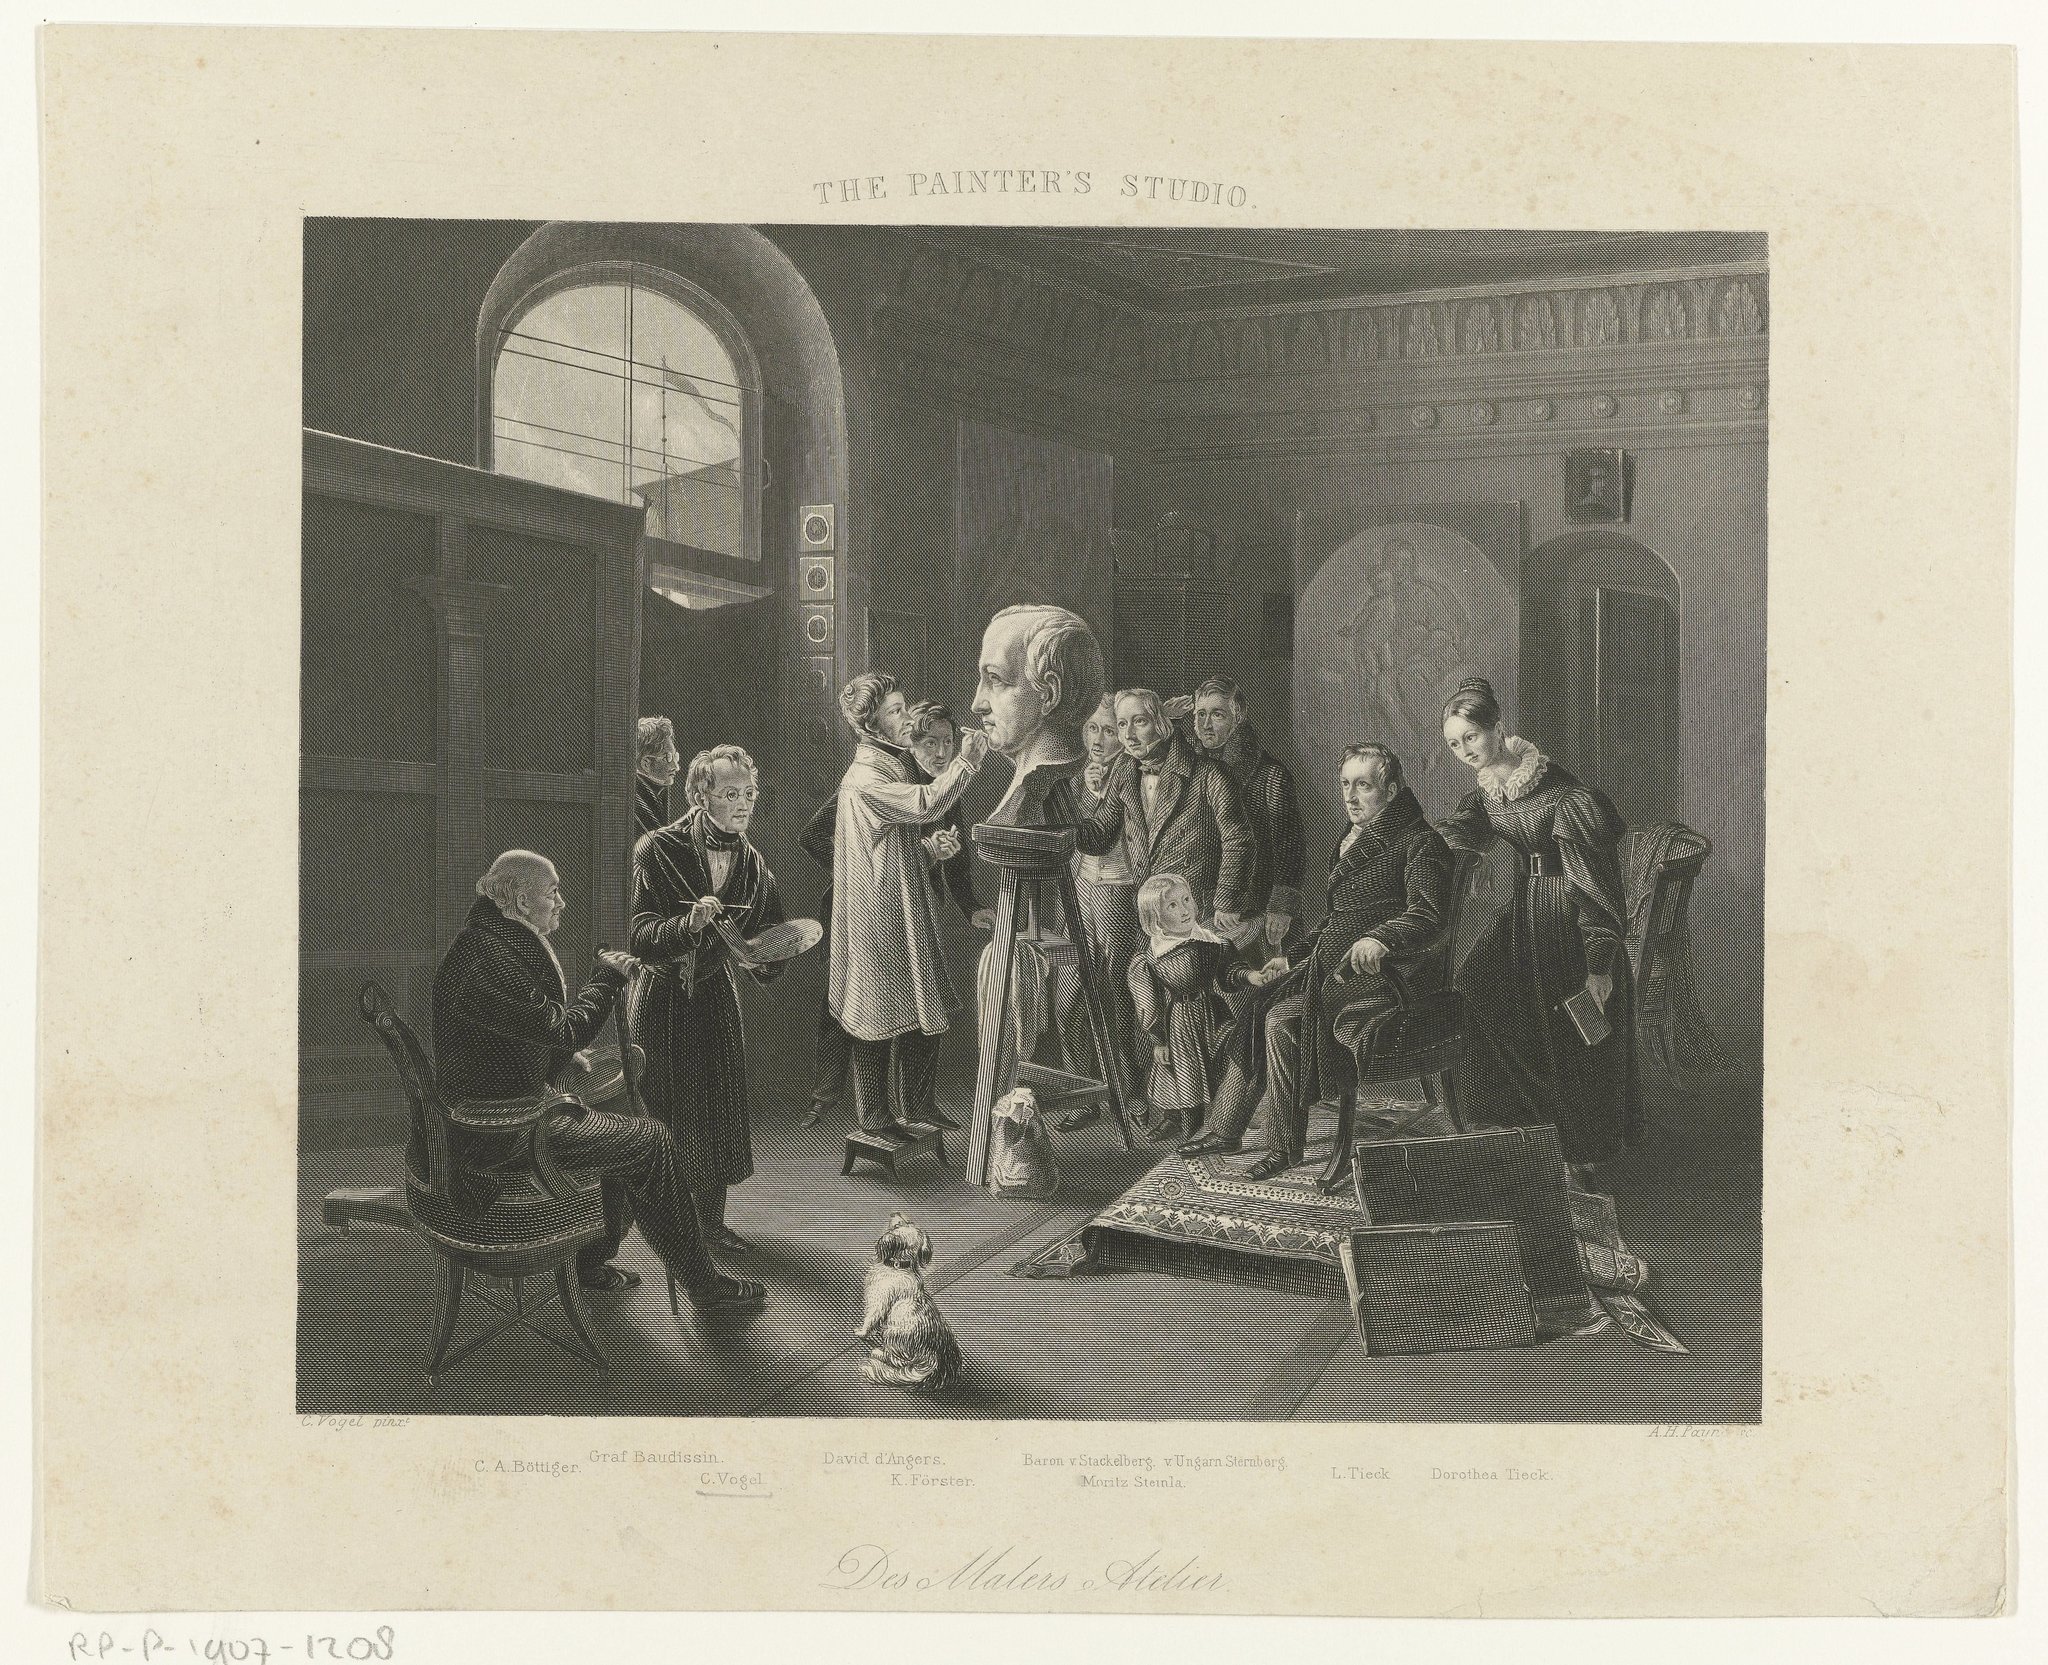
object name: print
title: The Painter's Studio / Des Malers Ateliers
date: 1845-1902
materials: paper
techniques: etching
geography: leipzig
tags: berlin, painter, print maker, moritz steinla, paris, pierre jean david d'angers, sculptor at work, historical persons, artist at work, in his workshop, dog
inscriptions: collector's mark: Lugt 2228